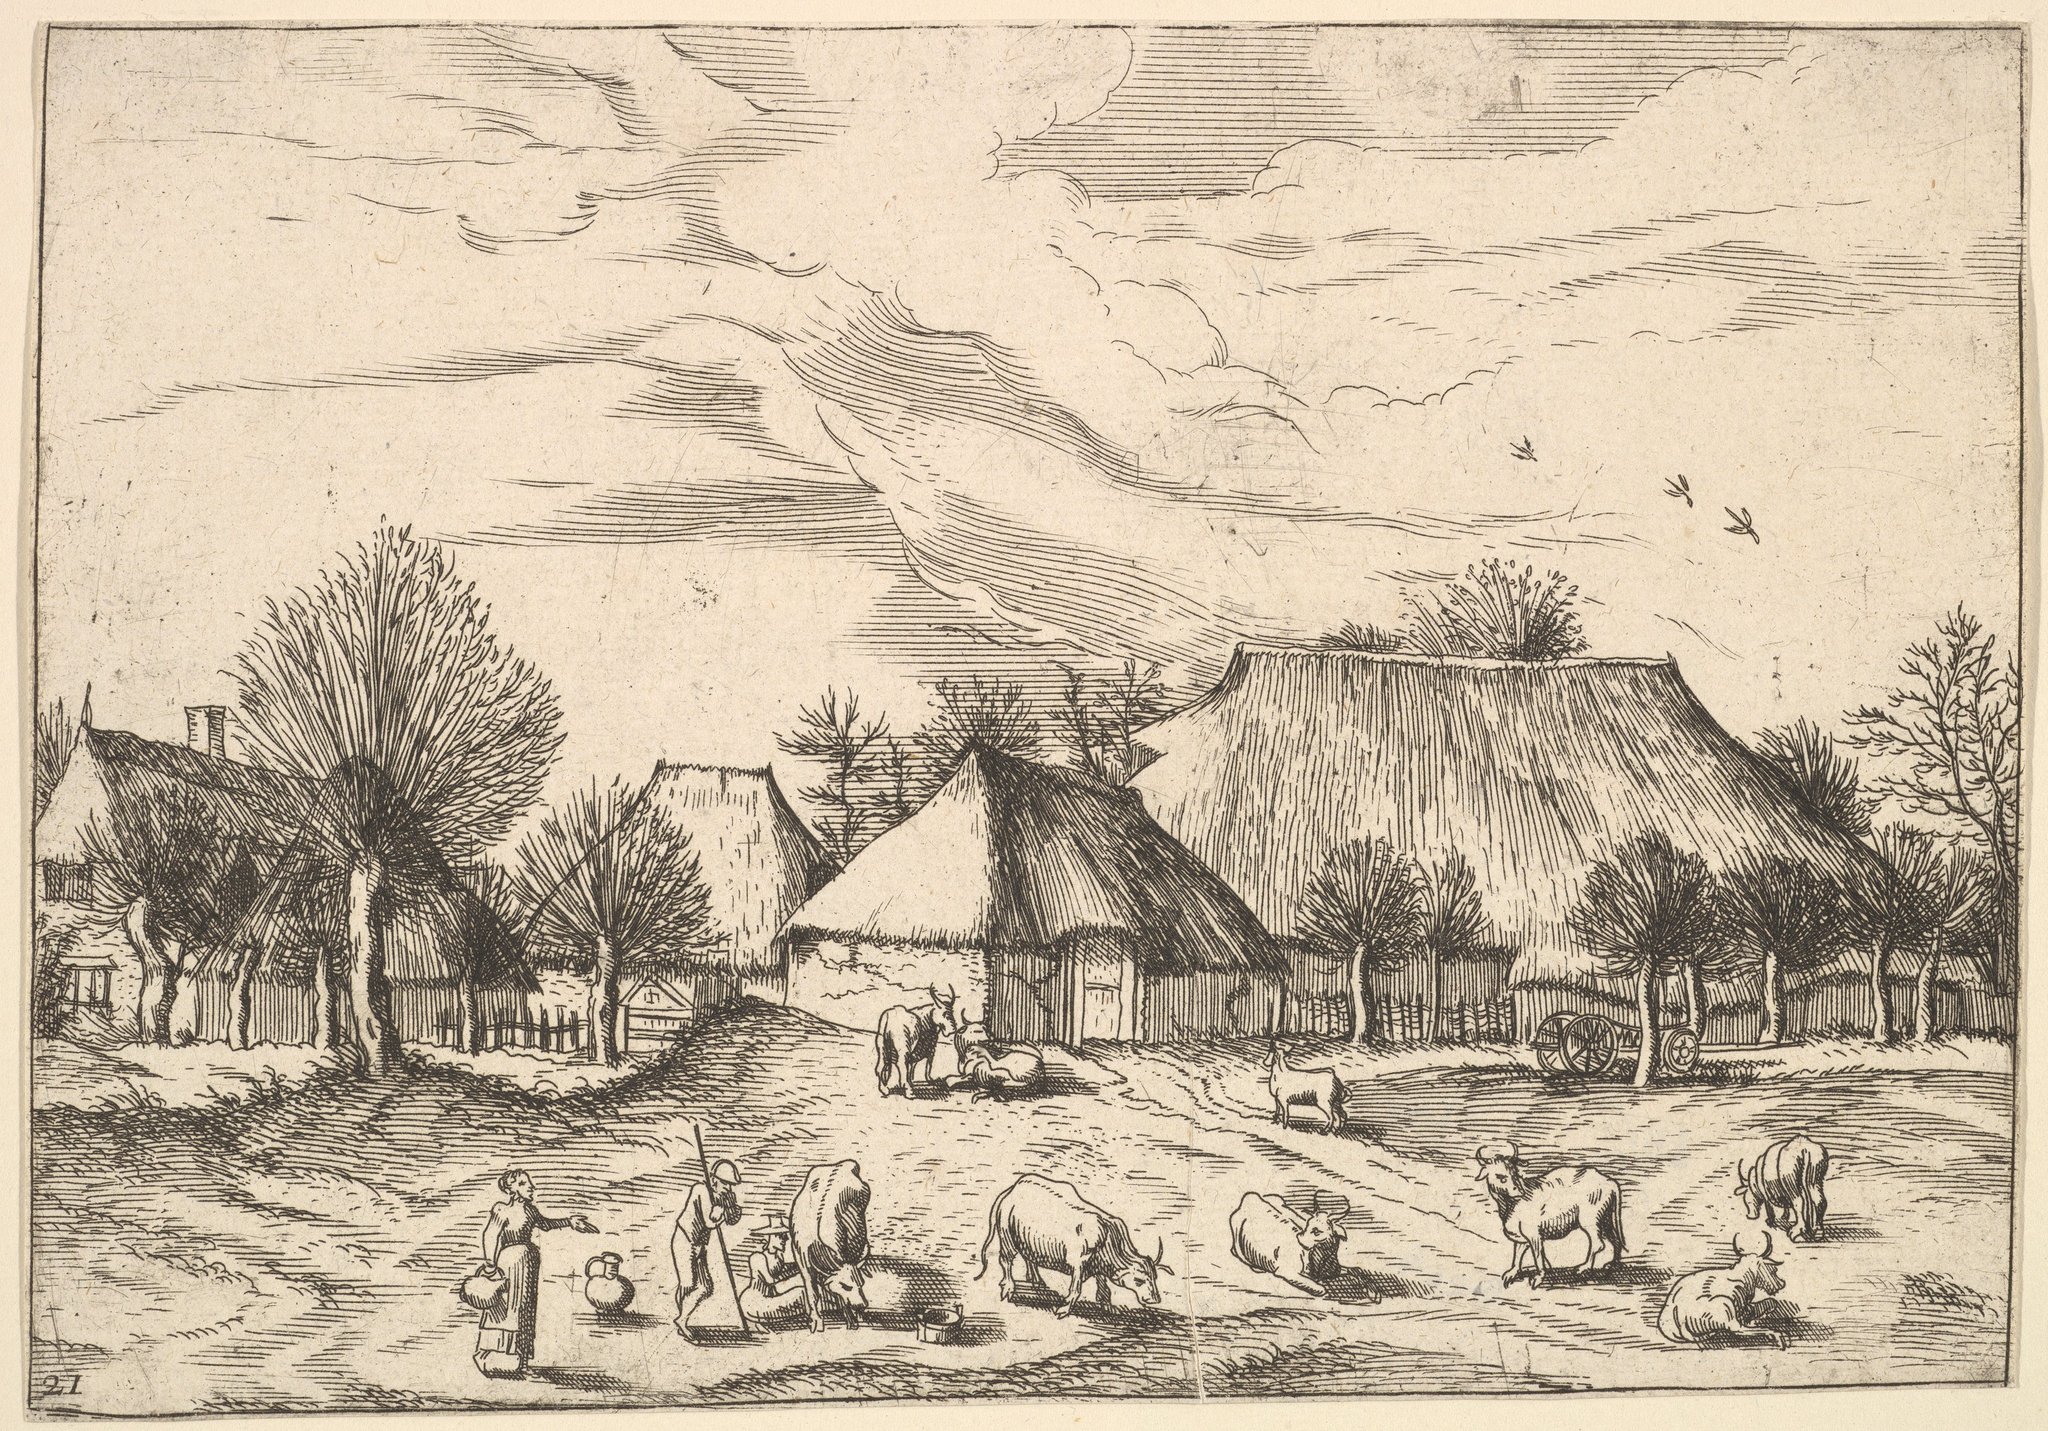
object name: print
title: Farms, cattle with herdsmen and milkmaids in the foreground from Multifariarum casularum ruriumque lineamenta curiose ad vivum expressa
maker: johannes van doetecum i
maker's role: artist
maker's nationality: netherlandish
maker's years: 1528-1605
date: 1559-1561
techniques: etching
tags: farms,men,women,cows,landscapes